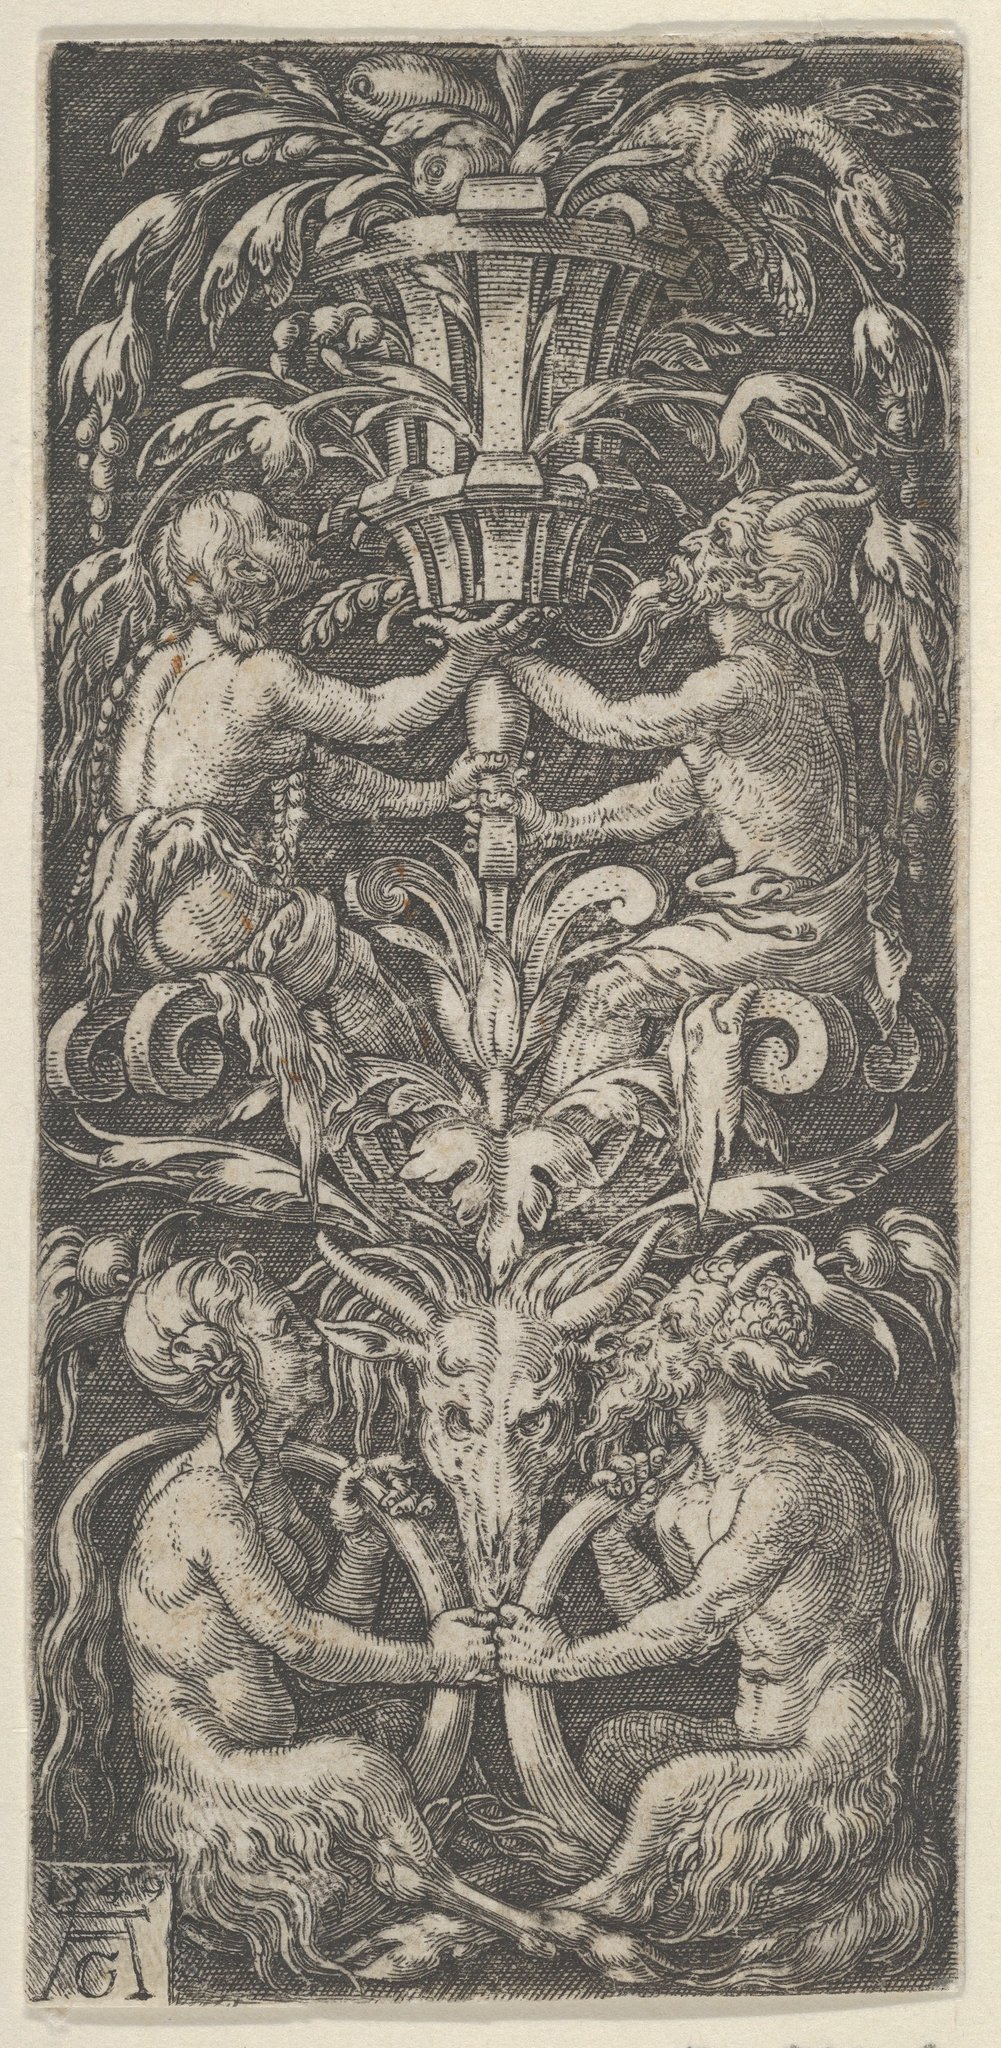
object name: print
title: Panel with Candelabrum Containing Two Couples of Satyrs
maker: heinrich aldegrever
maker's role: artist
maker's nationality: german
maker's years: 1502-1561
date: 1549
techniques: engraving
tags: satyrs,candelabra